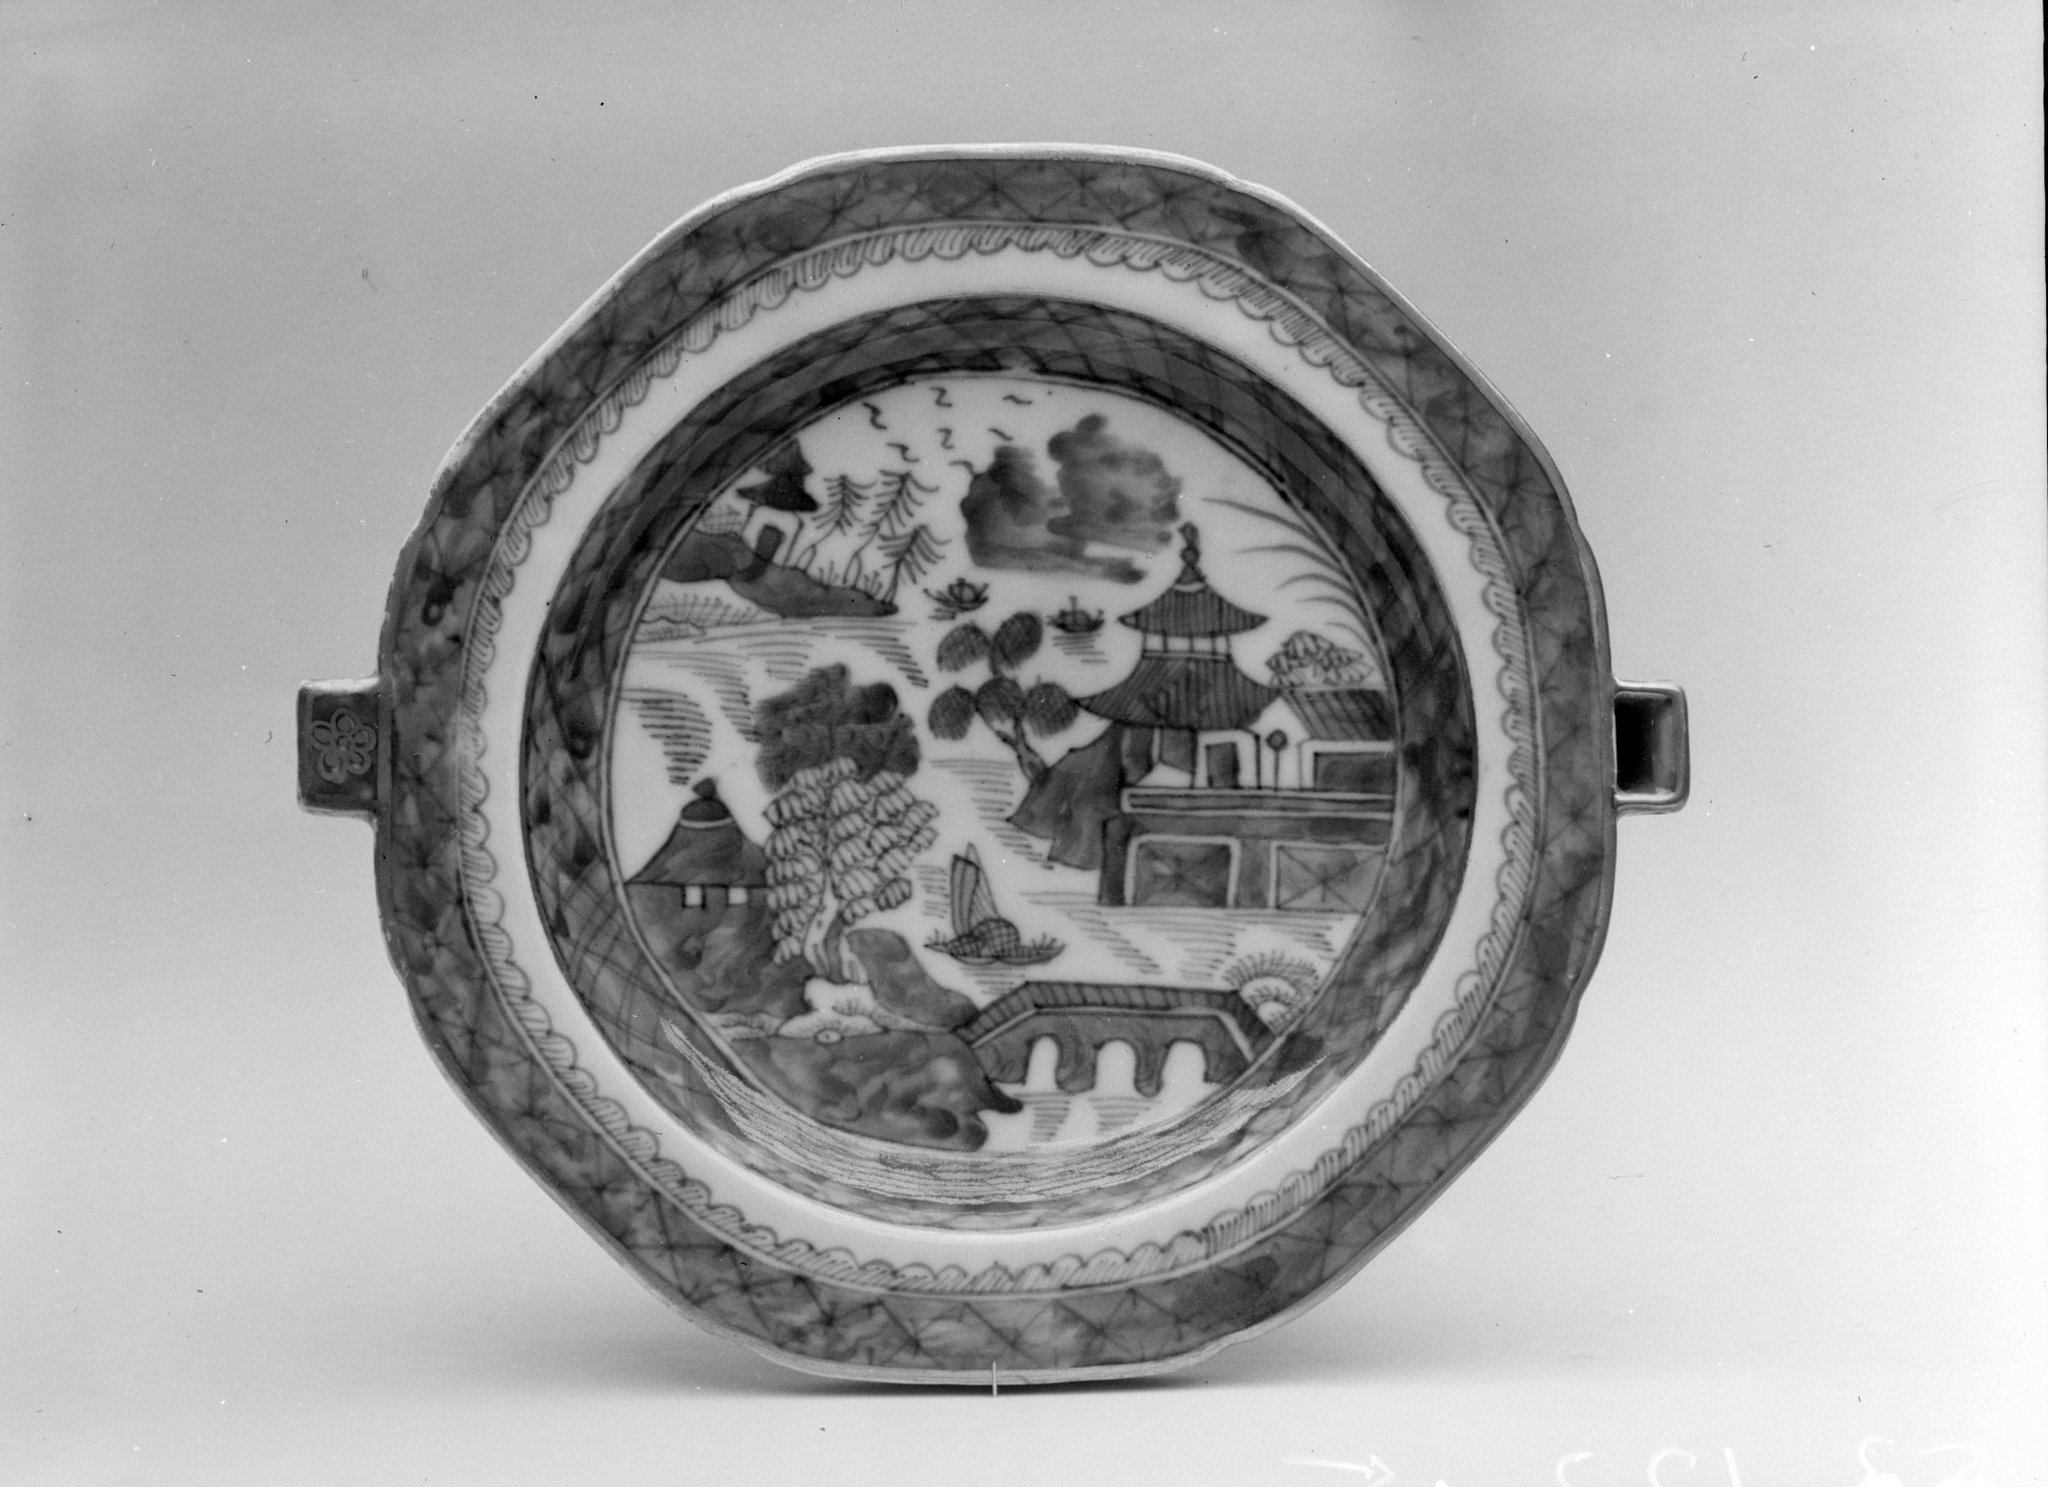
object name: hot water plate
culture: chinese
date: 1800-1830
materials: porcelain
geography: china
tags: landscapes